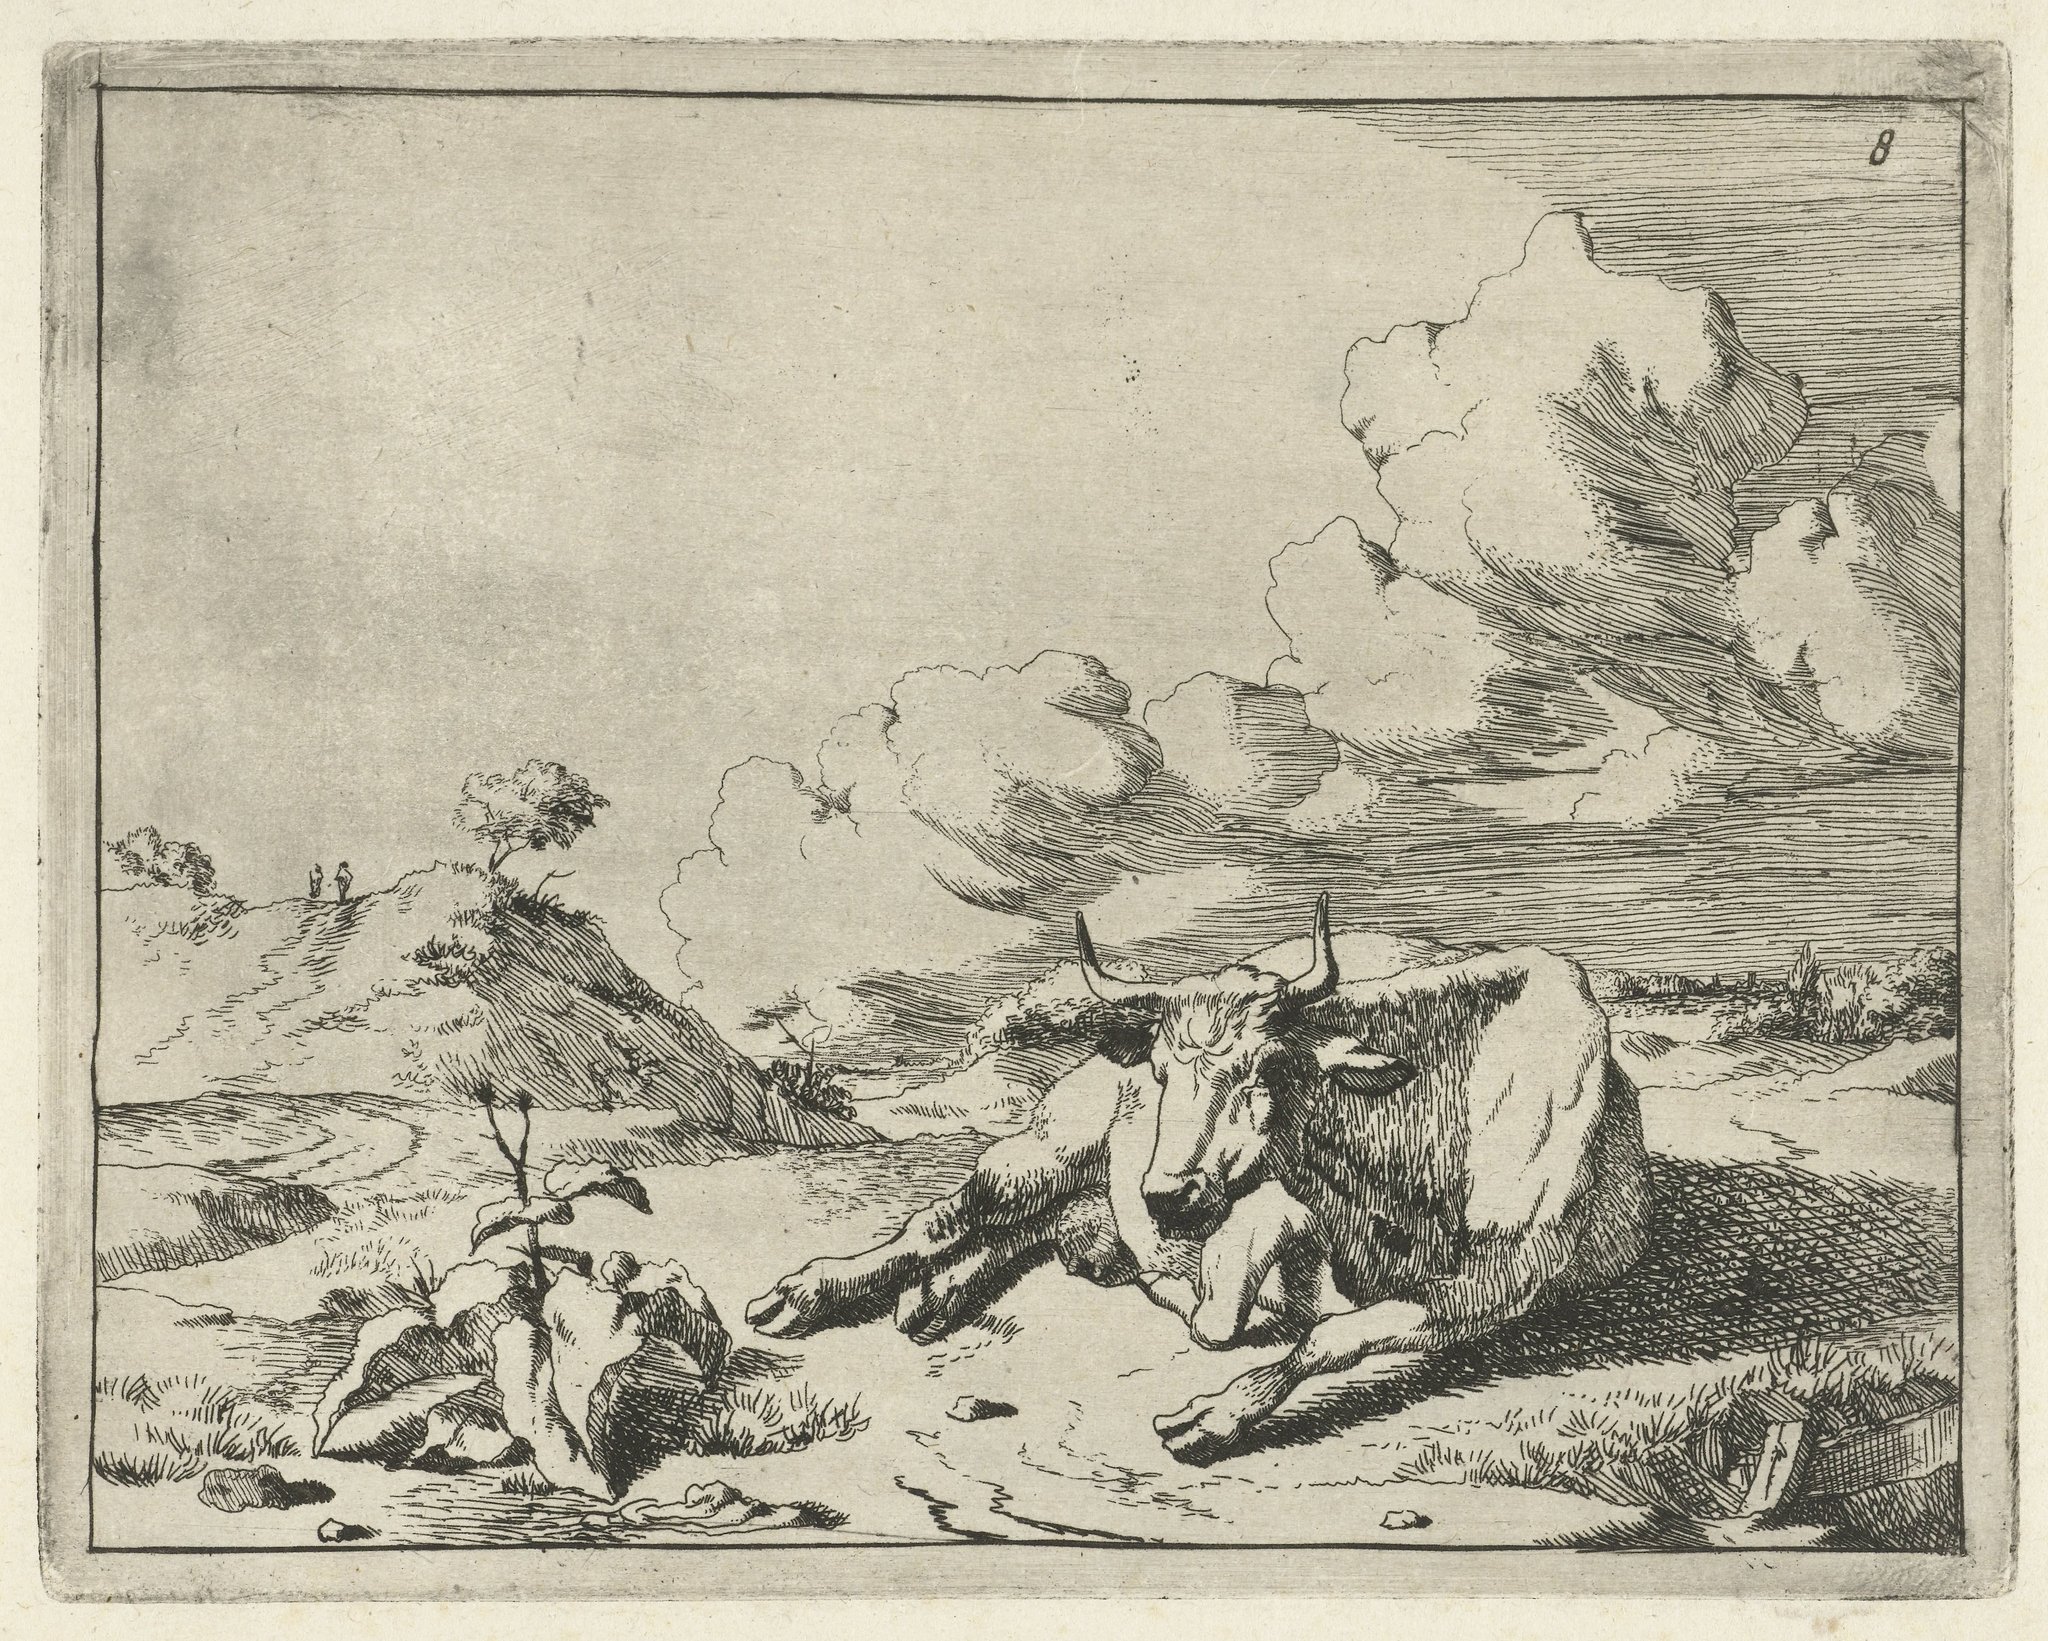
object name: print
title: Liggende koe van voren gezien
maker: marcus de bye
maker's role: print maker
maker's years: 1639-1688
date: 1657-1677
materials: paper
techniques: etching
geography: the hague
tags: cow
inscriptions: collector's mark: Lugt 240